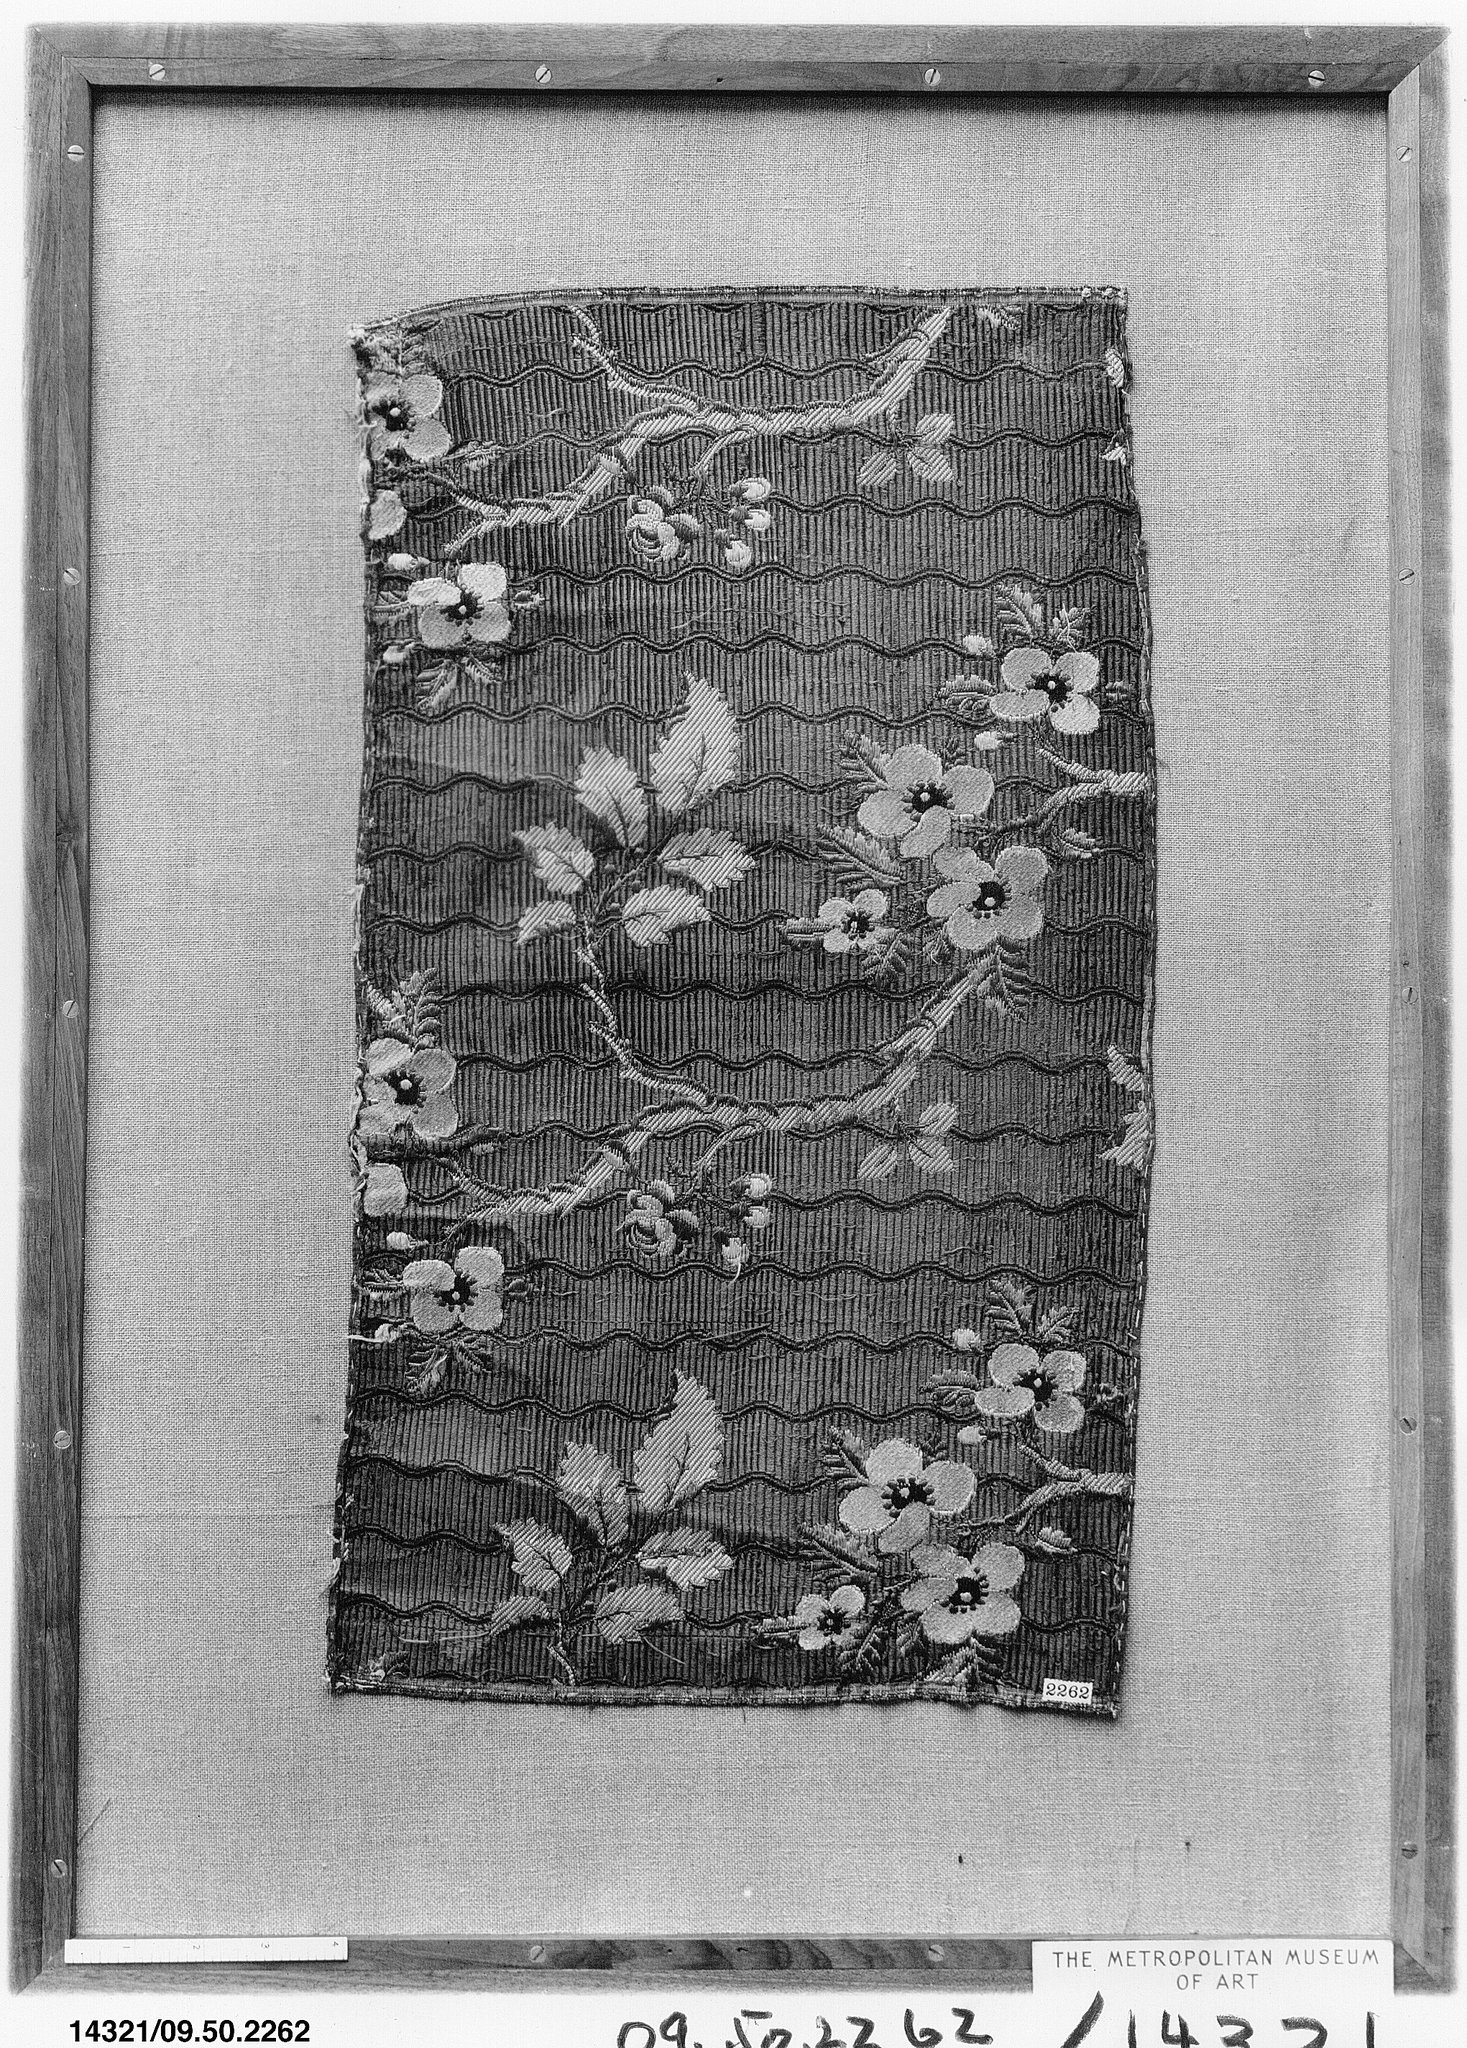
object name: piece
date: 1760-1770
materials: silk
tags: flowers,leaves